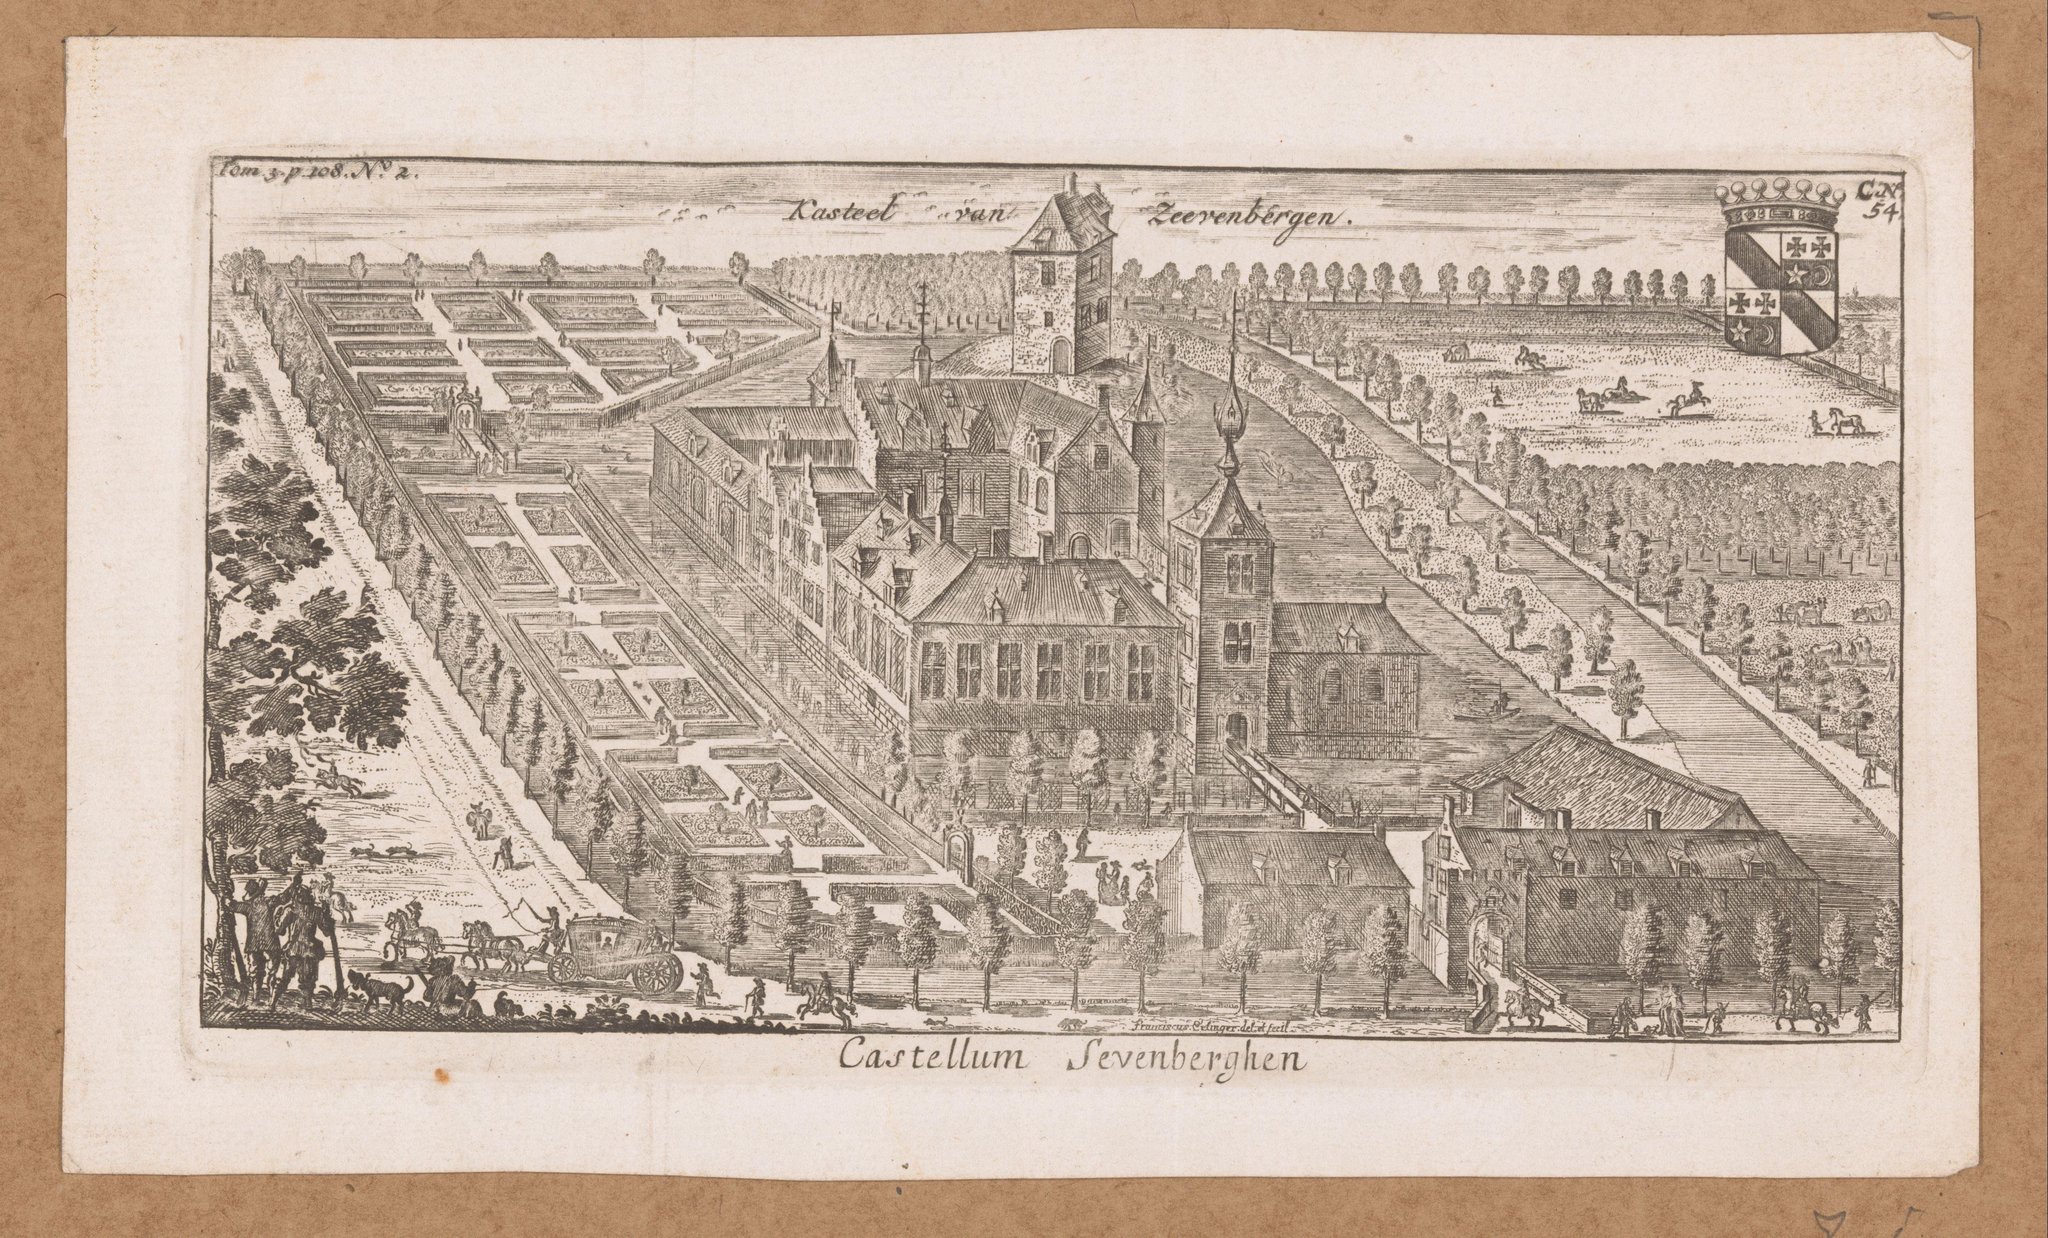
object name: book illustration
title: Gezicht op kasteel Zevenbergen bij Ranst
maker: franz ertinger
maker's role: print maker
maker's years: 1640-1710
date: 1678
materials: paper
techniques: engraving, etching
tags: castle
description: Van deze prent bestaan in ieder geval vijf staten. De eerste staat is gebruikt in Jacques le Roys 'Notitia Marchionatus Sacri Romani Imperii (…)' uit 1678. De tweede en derde staat komt voor in latere uitgaven van Le Roys werk (tweede: 1692, 1699, 1705, 1706; derde: 1730). De vierde staat is gebruikt in Philippe de Cantillons 'Delices du Brabant et de ses campagnes (…)' (1757). De huidige (vijfde) staat komt voor in: Cantillon, Philippe de. Vermakelykheden van Brabant, en deszelfs onderhoorige landen (…). 4 dln. 1e druk. Amsterdam: David Weege, 1770, dl. 3. En in: Cantillon, Philippe de. Vermakelykheden van Brabant, en deszelfs onderhoorige landen (…). 4 dln. 2e druk. Utrecht: Gijsbert Tieme van Paddenburg en Justus Visch, 1777, dl. 3.